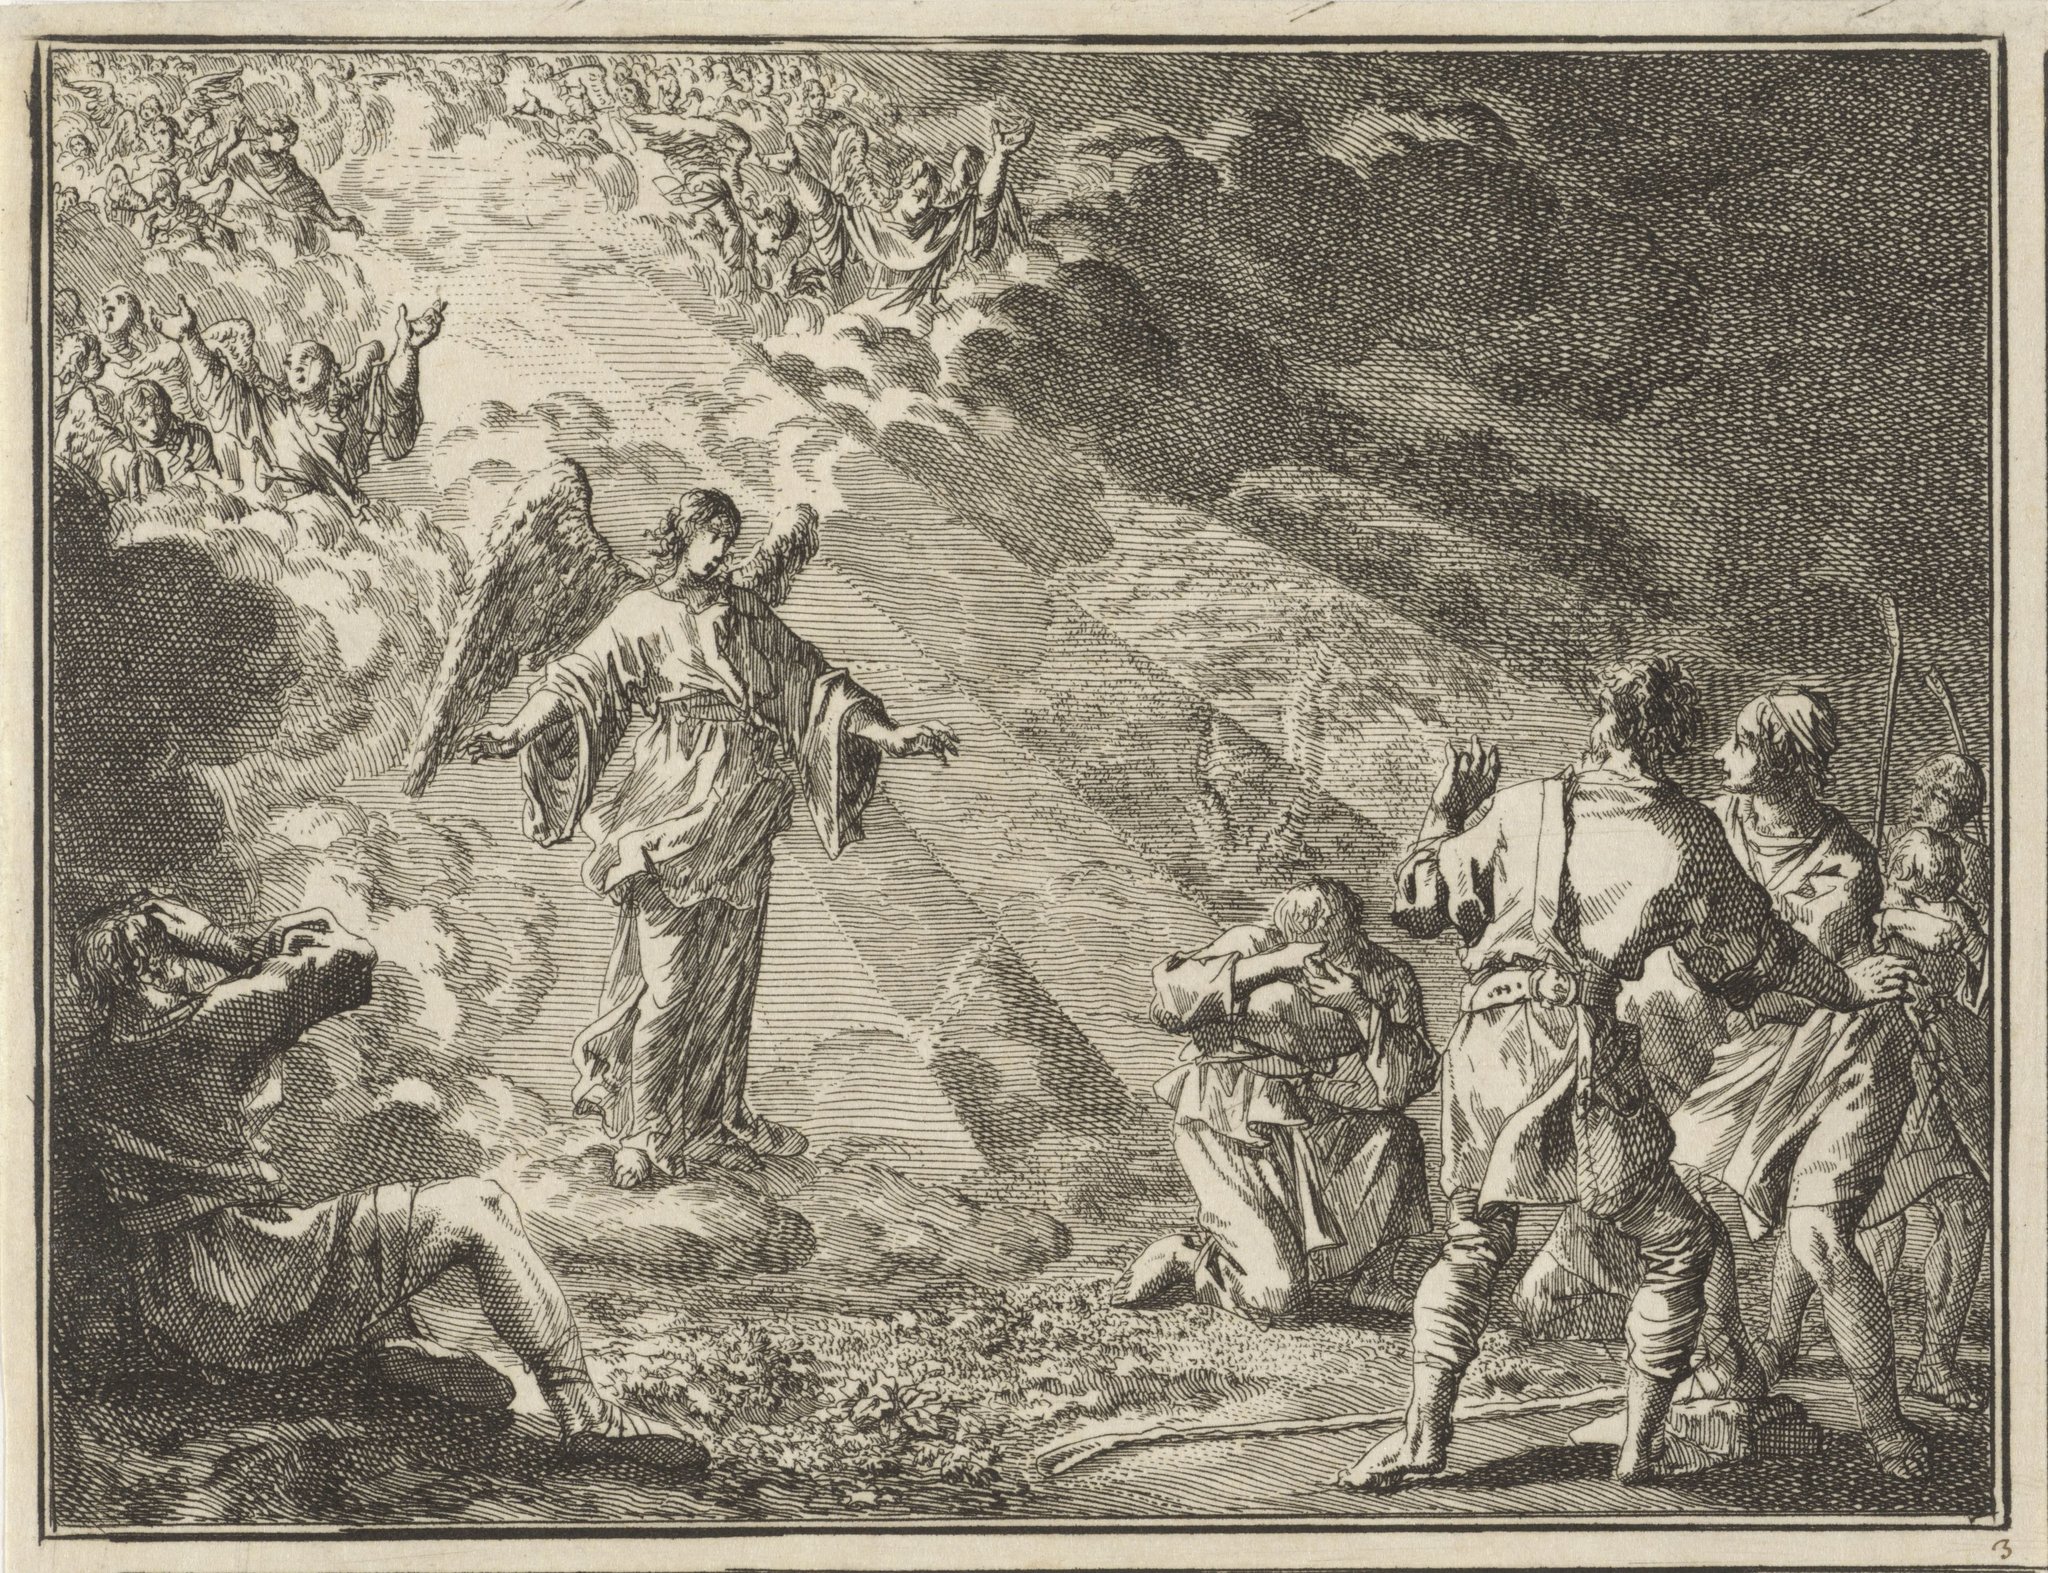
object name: print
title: Verkondiging aan de herders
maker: jan luyken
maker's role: draughtsman, print maker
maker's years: 1649-1712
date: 1712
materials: paper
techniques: etching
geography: amsterdam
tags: annunciation of christ's birth to the shepherds (and/or shepherdesses) at night; a host of singing angels in the air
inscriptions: number: ‘3’, collector's mark: Lugt 2228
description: Proefdruk van illustratie uit: Luyken, Jan. De schriftuurlyke geschiedenissen en gelykenissen van het Oude en Nieuwe Verbond, 2 delen. Amsterdam: Wed. Pieter Arentsz II en Cornelis van der Sys, 1712, dl. II.